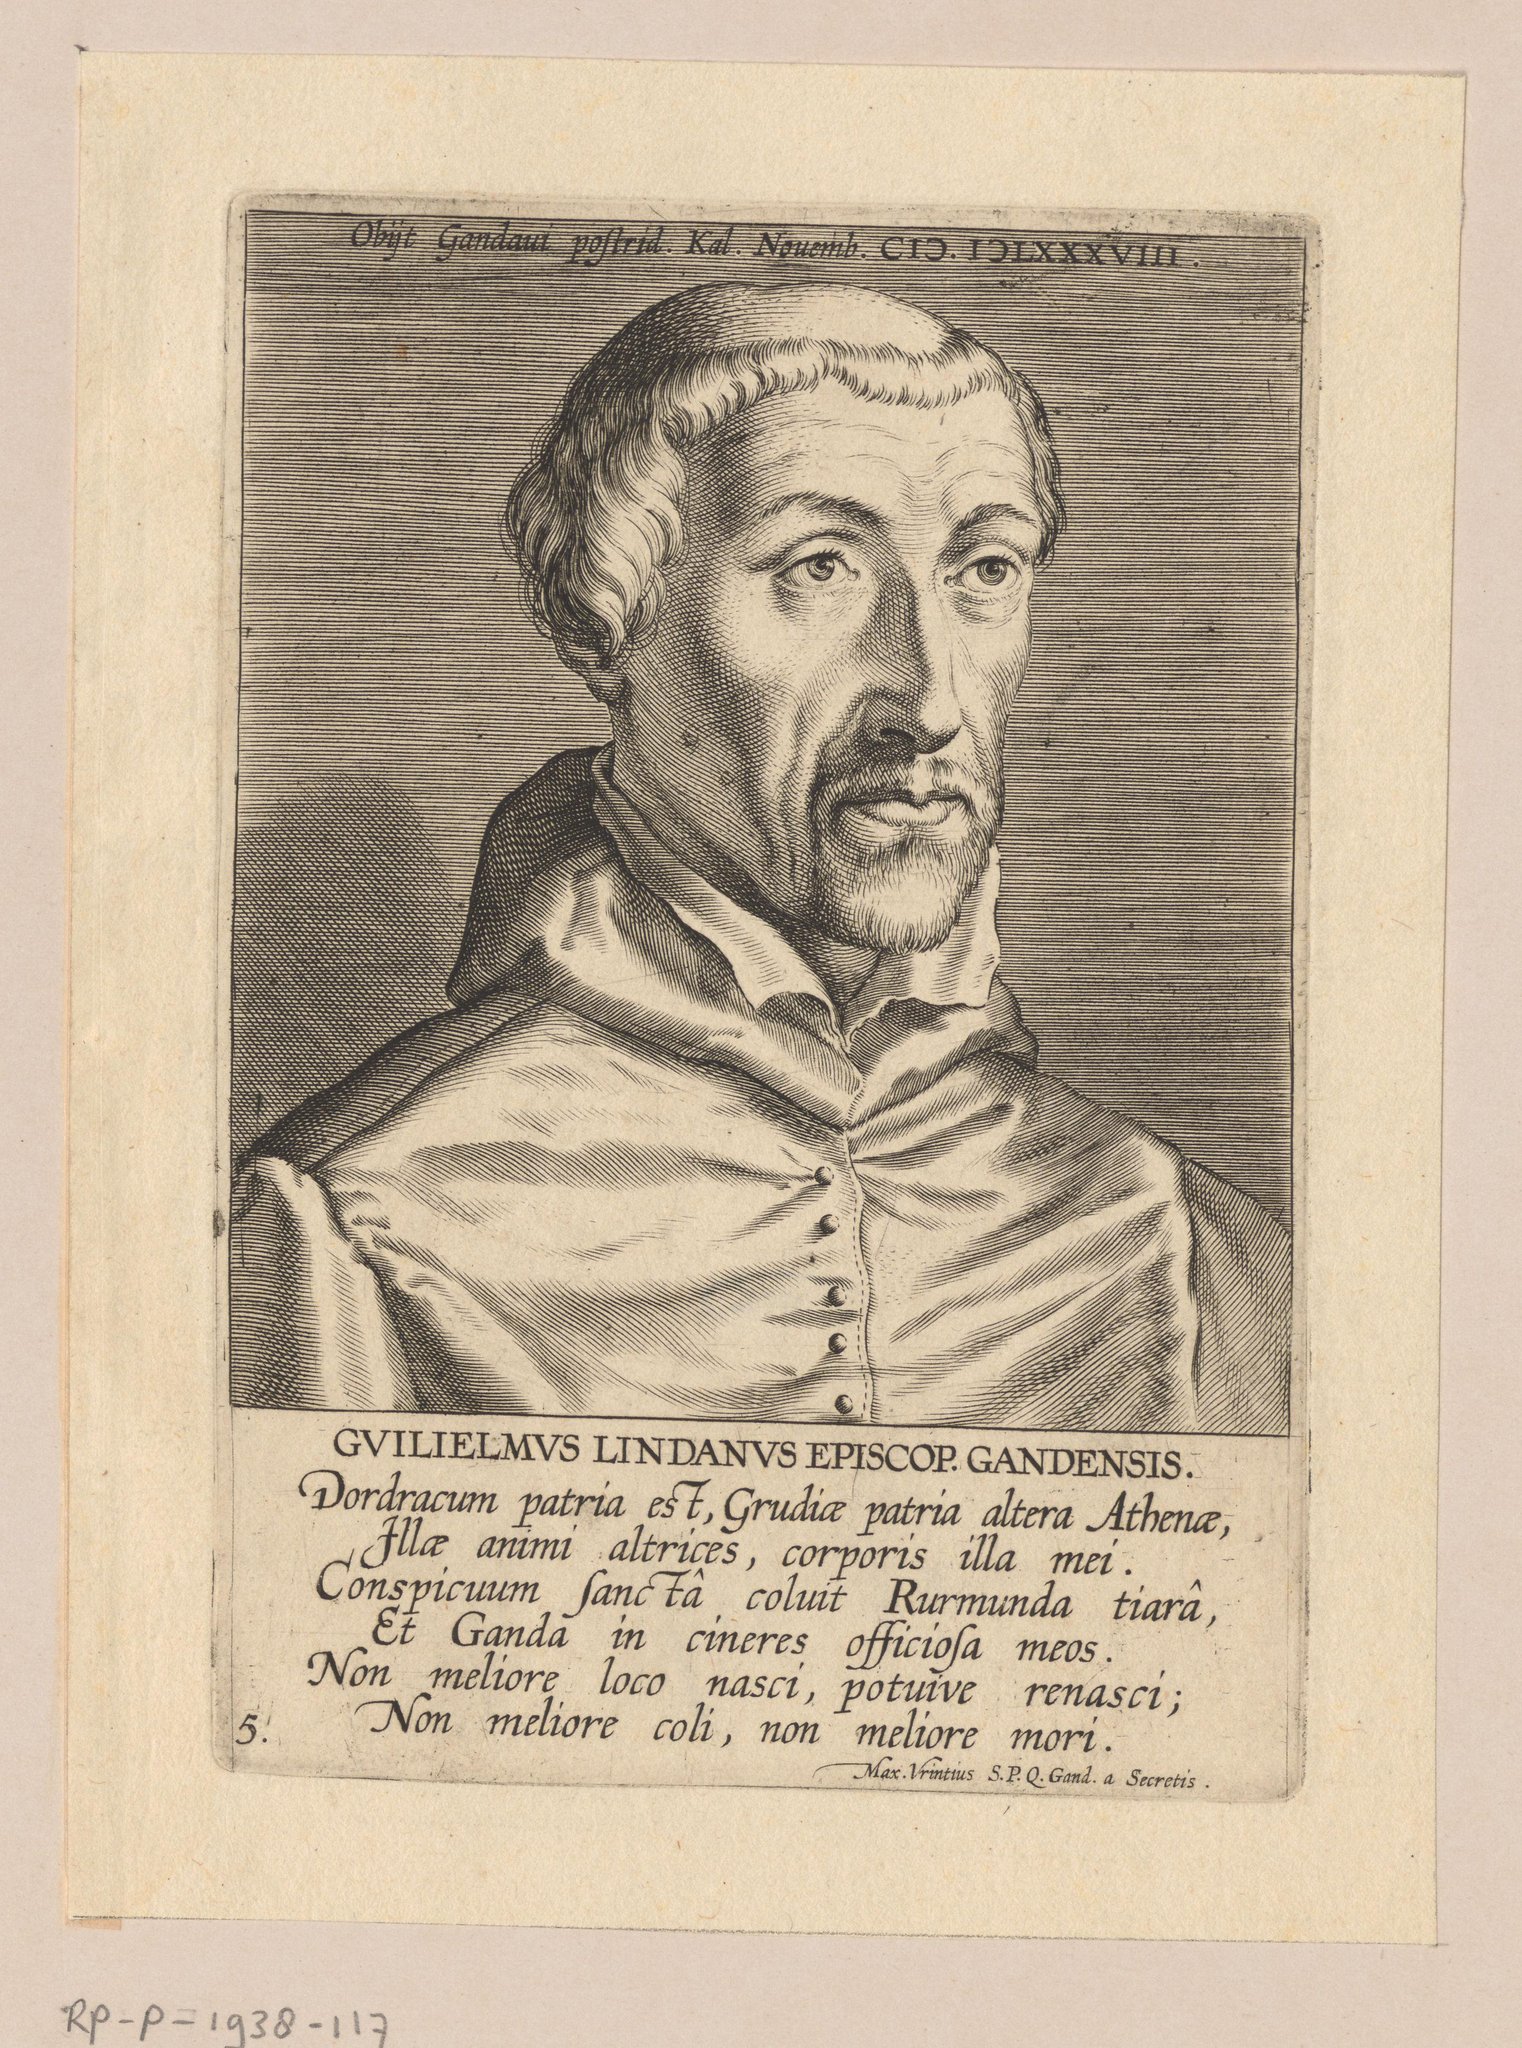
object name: print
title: Portretten van beroemde Nederlandse en Vlaamse geleerden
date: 1604-1608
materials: paper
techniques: engraving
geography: antwerp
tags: dordrecht, archbishop, bishop, etc. (roman catholic), historical persons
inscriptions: collector's mark: Lugt 2228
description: De prent werd gebruikt in de edities van 'Illustrium Galliae Belgicae Sciptorum Icones et Elogi' uit 1604, 1606, 1608.